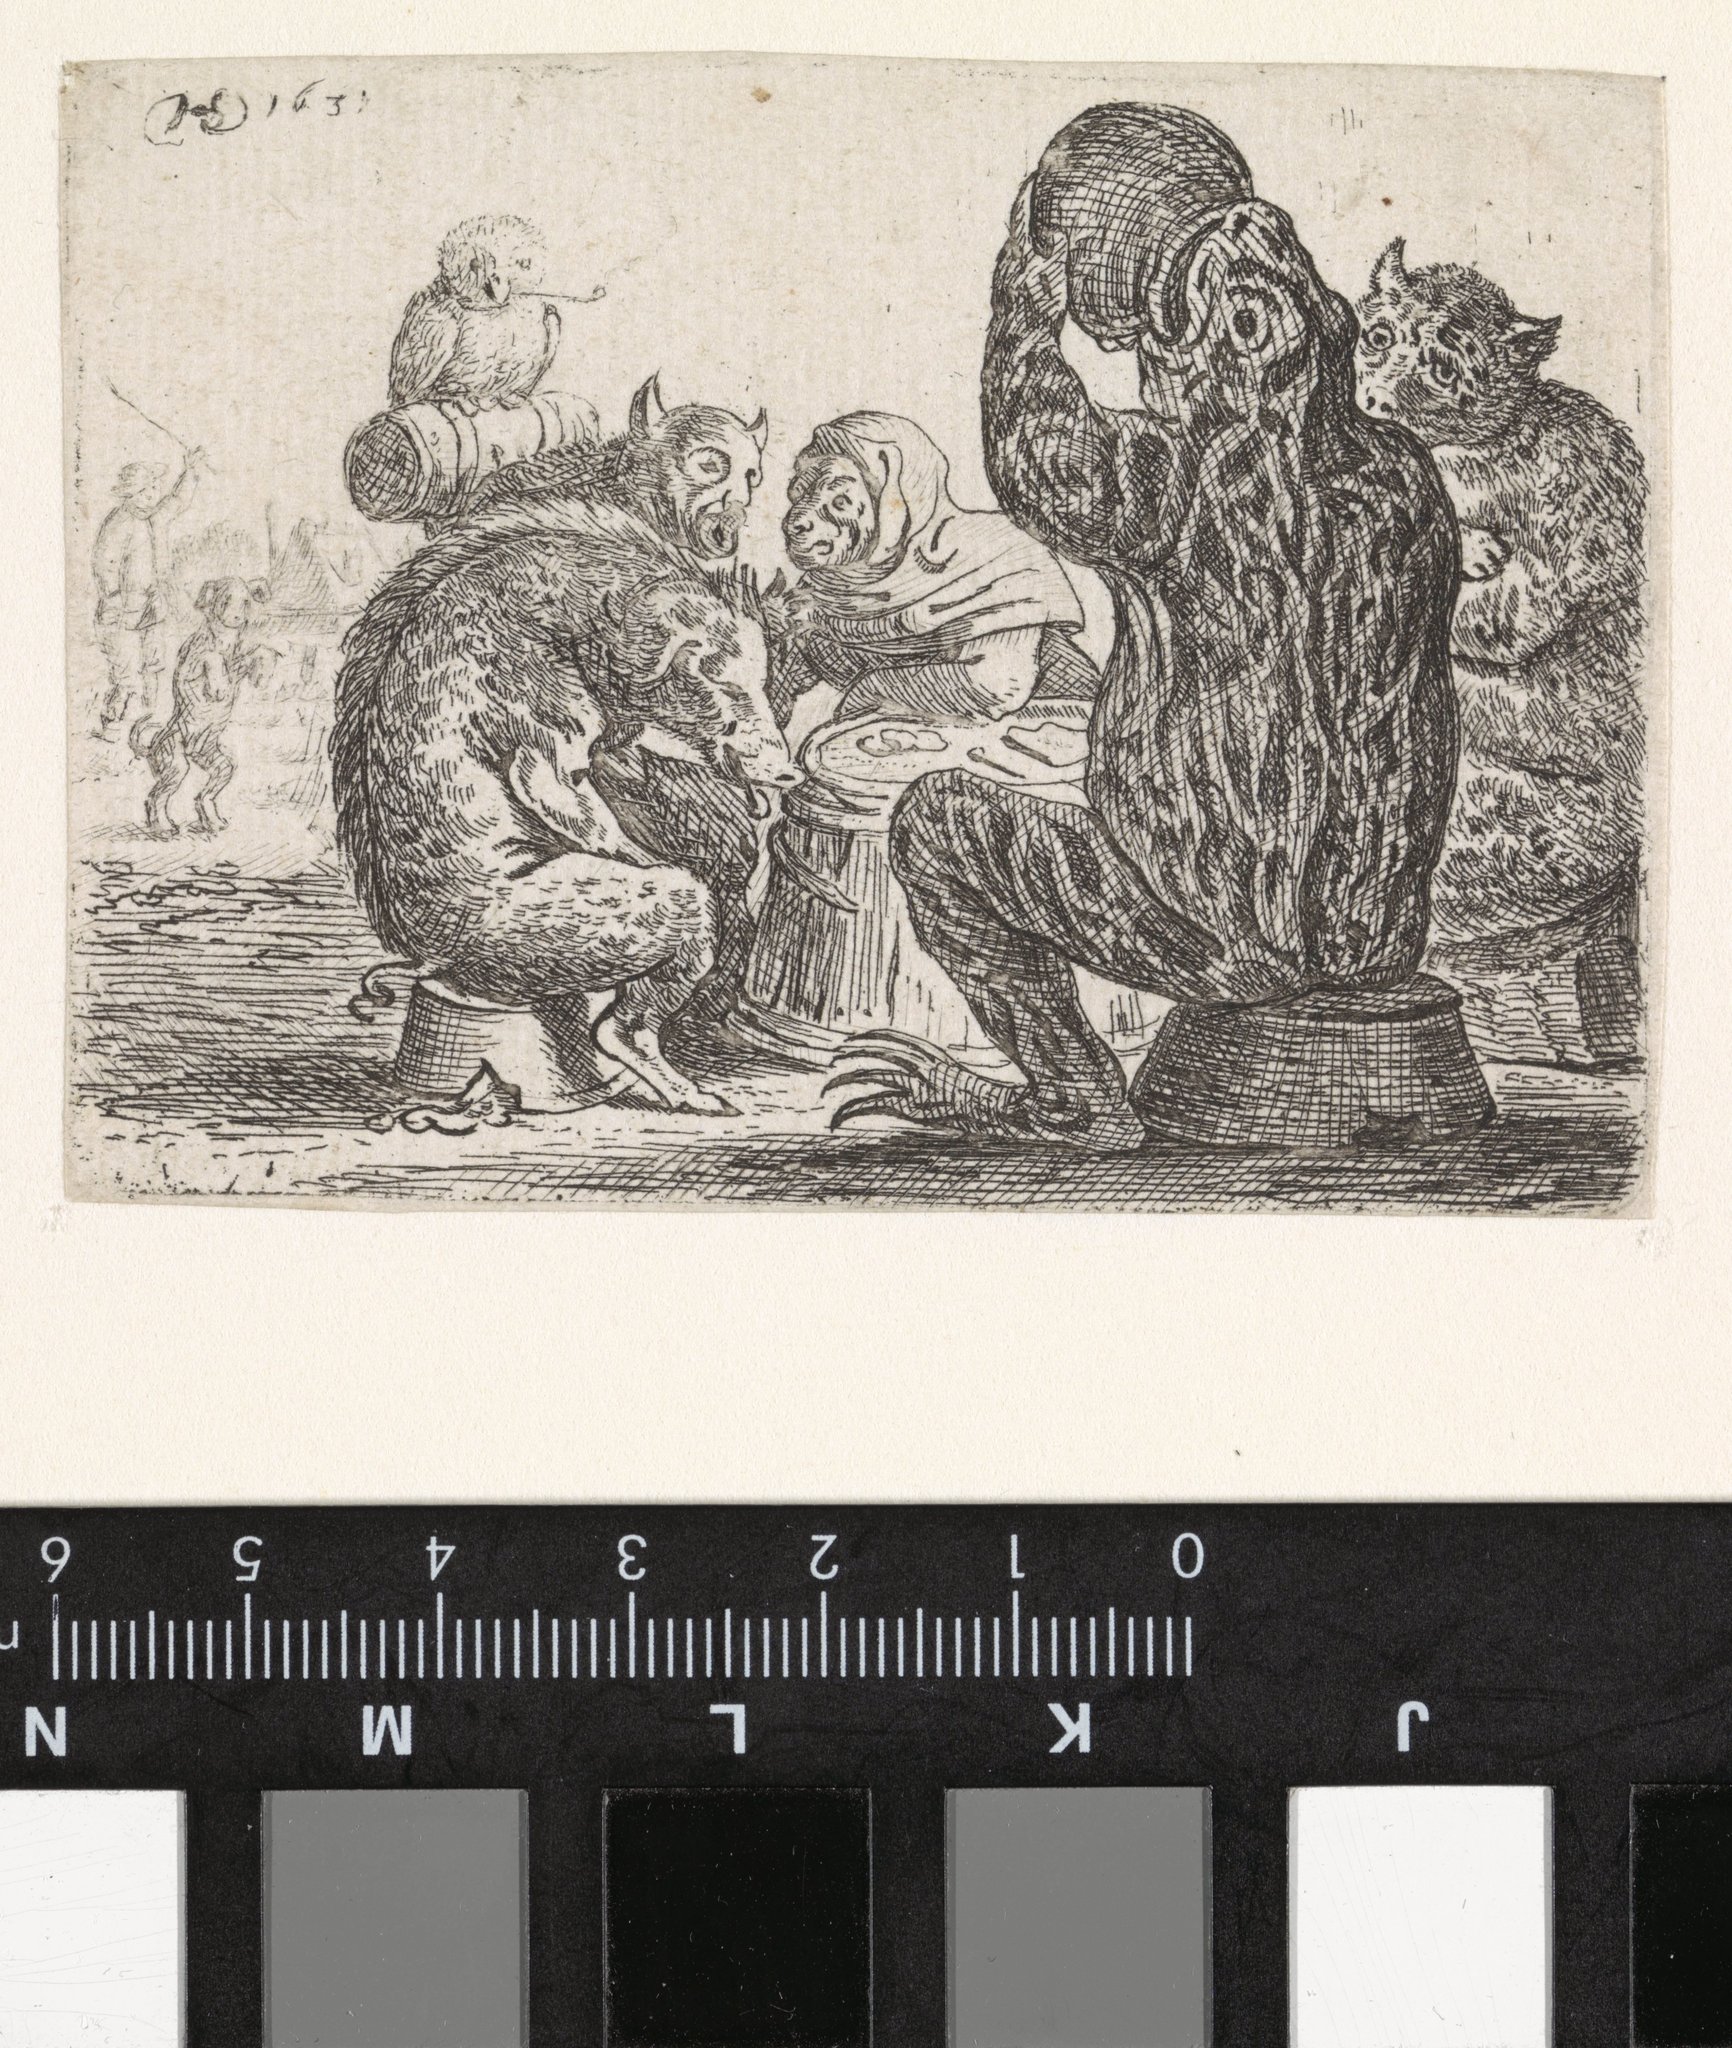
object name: print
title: Gezelschap van dieren rond een ton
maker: herman saftleven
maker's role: draughtsman, painter, print maker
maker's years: 1609-1685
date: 1634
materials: paper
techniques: etching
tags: tailless amphibians: frog, beasts of prey, predatory animals: panther, owls, eating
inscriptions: collector's mark: Lugt 240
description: Een pad, een zwijn een panter, een uil en andere dieren zitten rond een ton te eten en te roken. Op de achtergrond een man en een dansende hond.